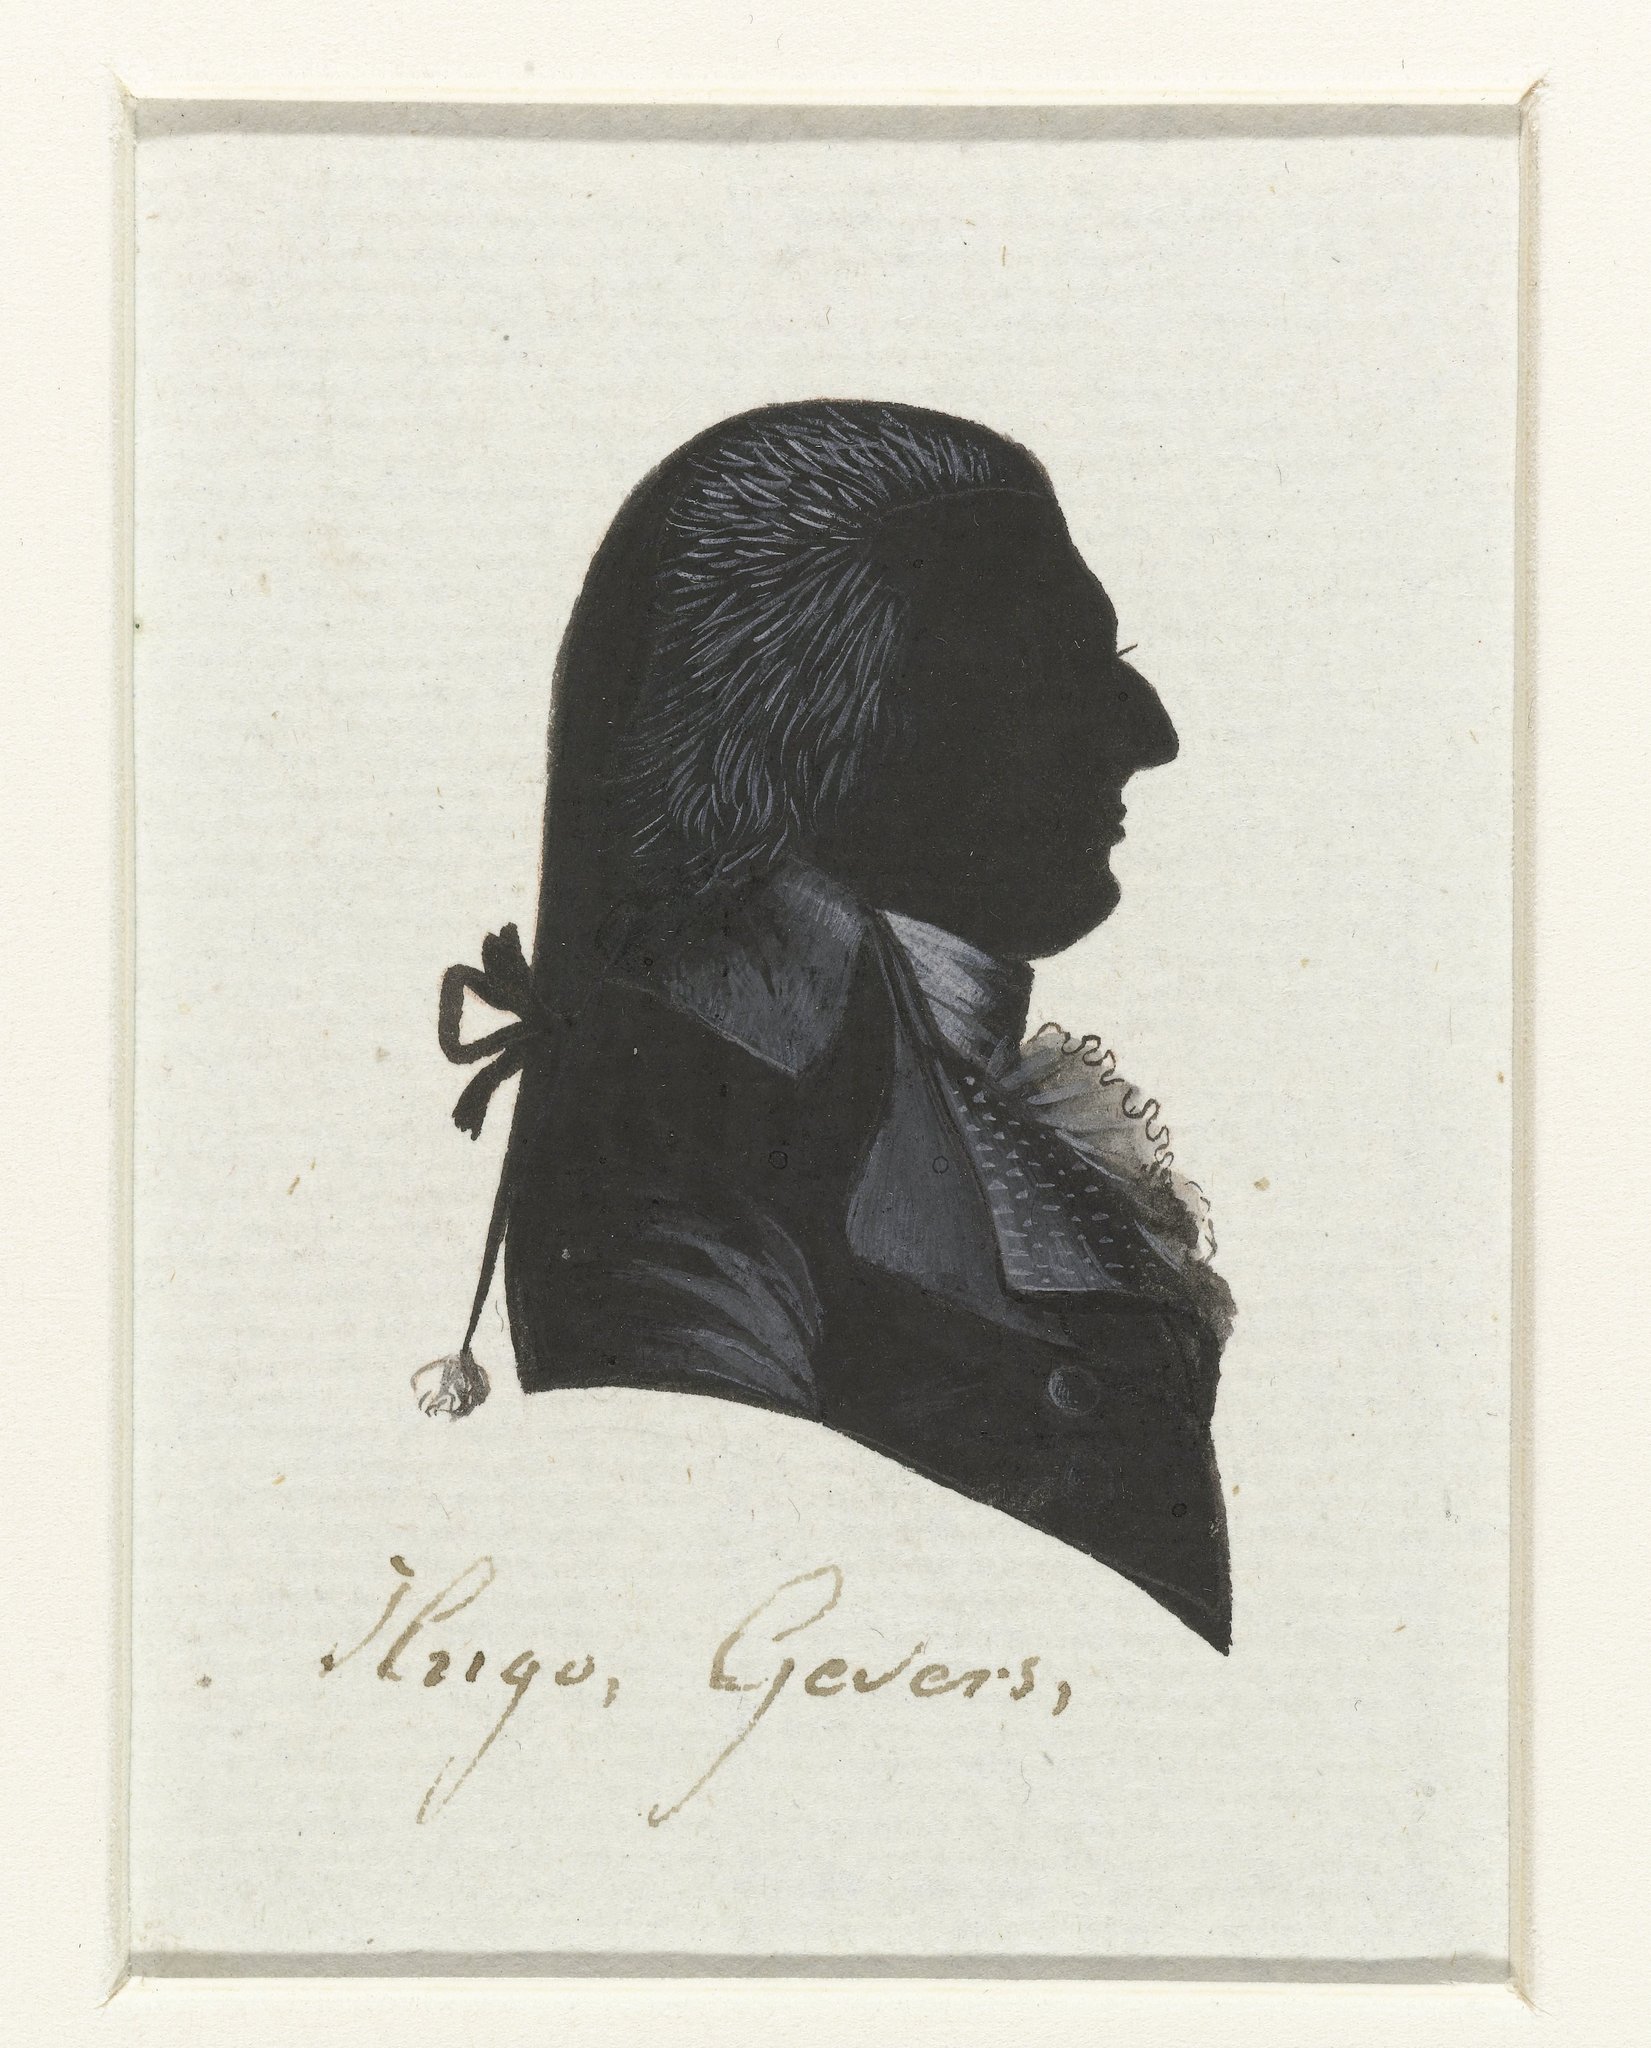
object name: silhouette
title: Representanten van de eerste Nationale Vergadering van de Bataafse Republiek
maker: hausdorff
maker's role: draughtsman, print maker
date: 1796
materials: ink, paper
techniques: drawing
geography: netherlands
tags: rotterdam, mayor, historical persons (+ profile portrait), the hague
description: Silhouettes of members of the National Assembly. India ink on paper, 1796. Early in 1795 Stadholder William V fled to England. In the Republic a new regime was installed. A year later, the country held its first general election. Every Dutch man over the age of twenty and not on poor relief was entitled to vote for a candidate to the National Assembly, the parliament of the Batavian Republic, as the country was known between 1795 and 1806. The 126 representatives who sat in the assembly were drawn from the educated, progressive elite of Dutch society.